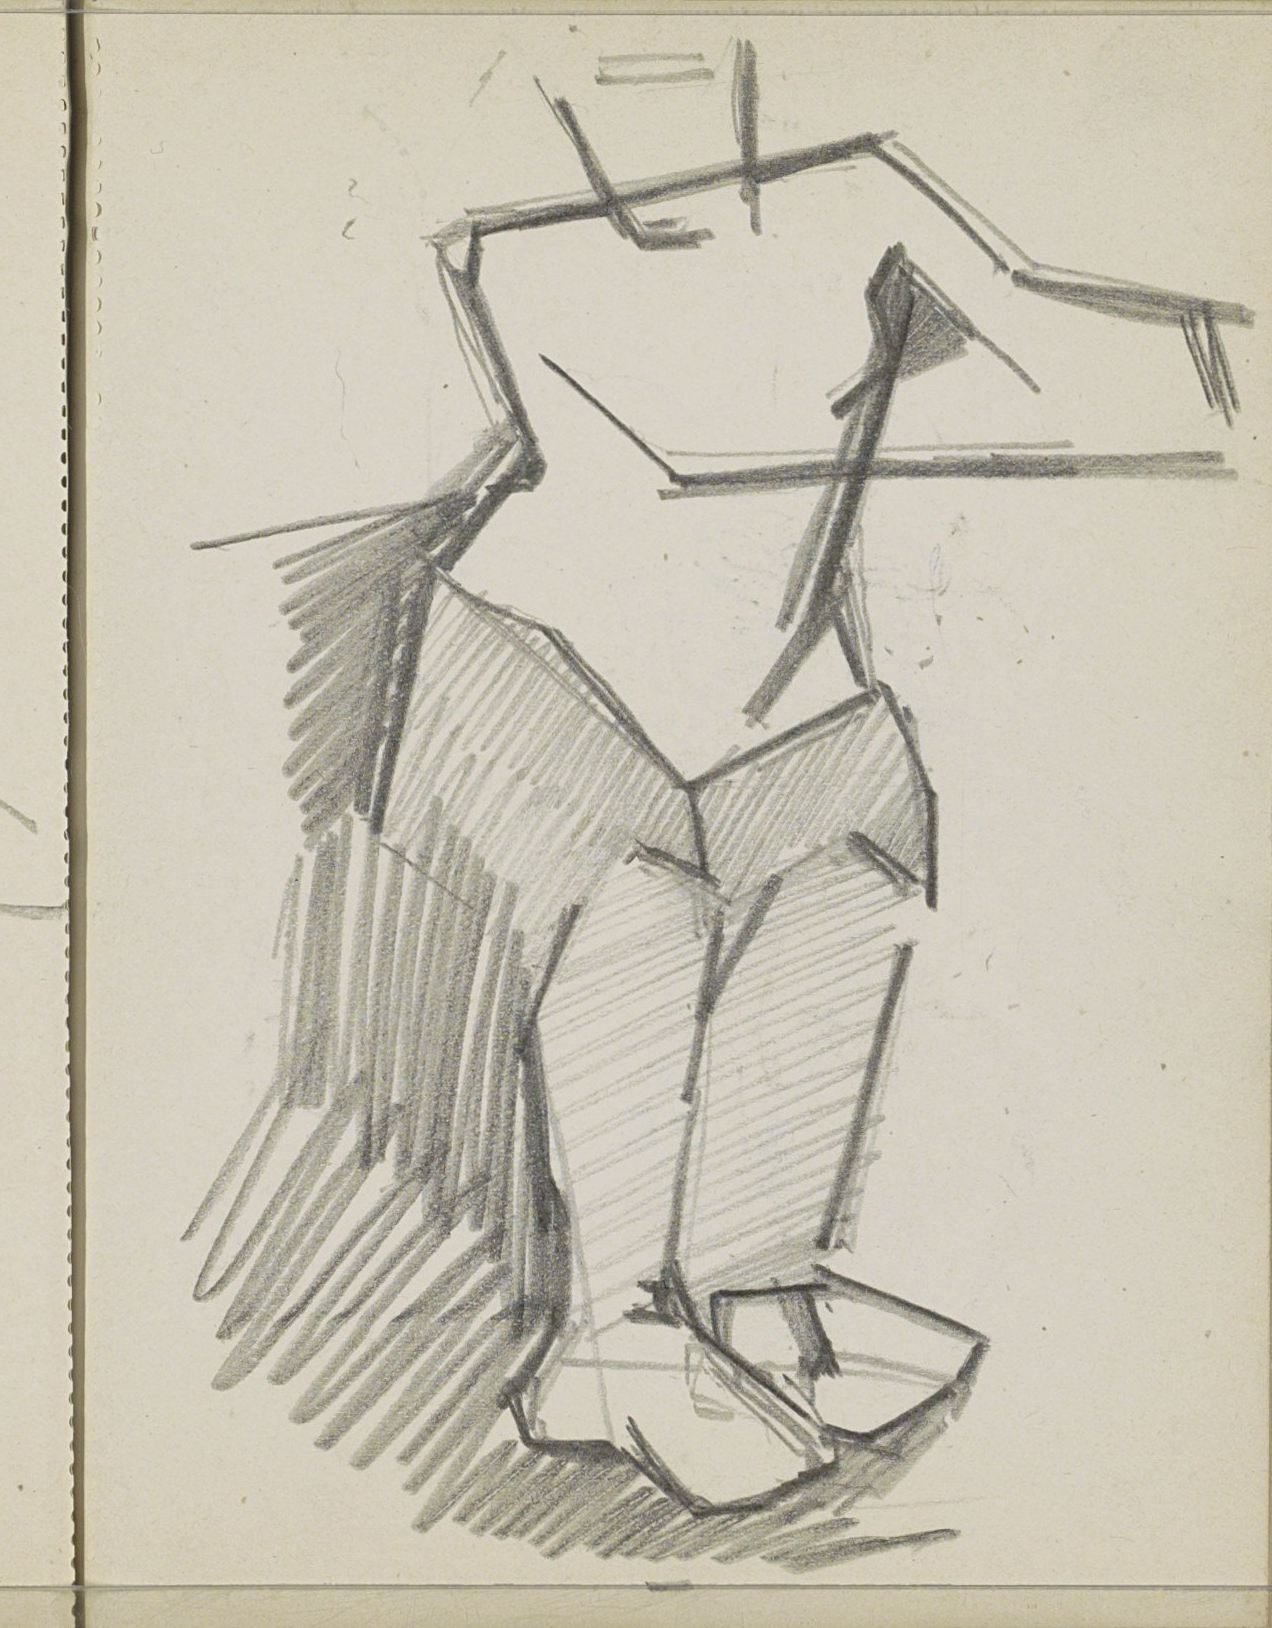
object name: sketchbook leaf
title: Staande figuur met gebogen knieën en opgeheven armen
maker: reijer stolk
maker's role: draughtsman, print maker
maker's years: 1896-1945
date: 1906-1945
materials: paper, pencil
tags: standing figure, arm stretched sidewards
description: Blad 43 recto uit een schetsboek met 53 bladen.